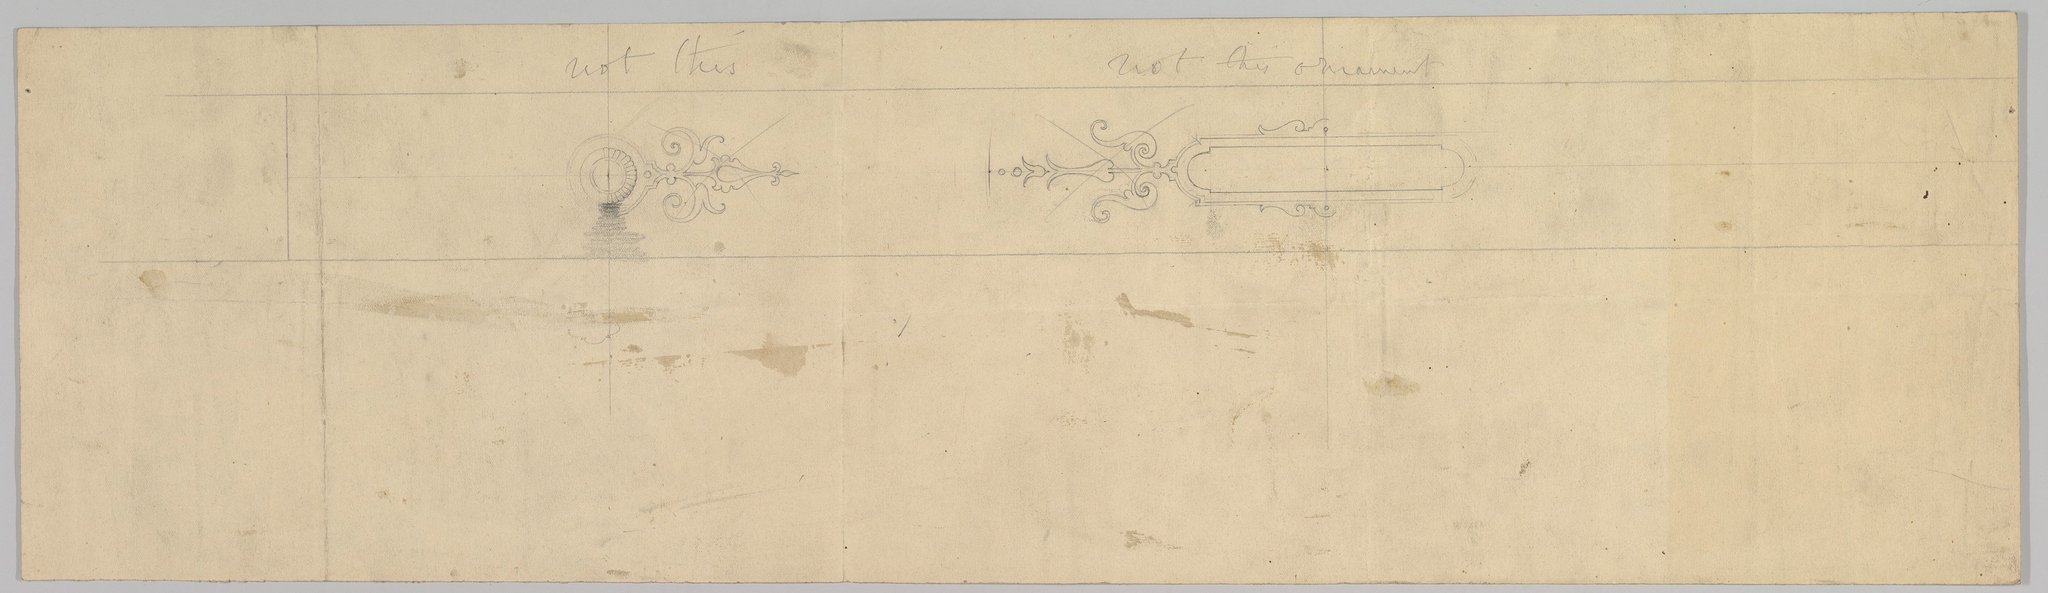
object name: drawing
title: Ornament Design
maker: john gregory crace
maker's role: artist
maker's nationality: british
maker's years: 1809-1889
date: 1801-1900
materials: graphite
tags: ornament